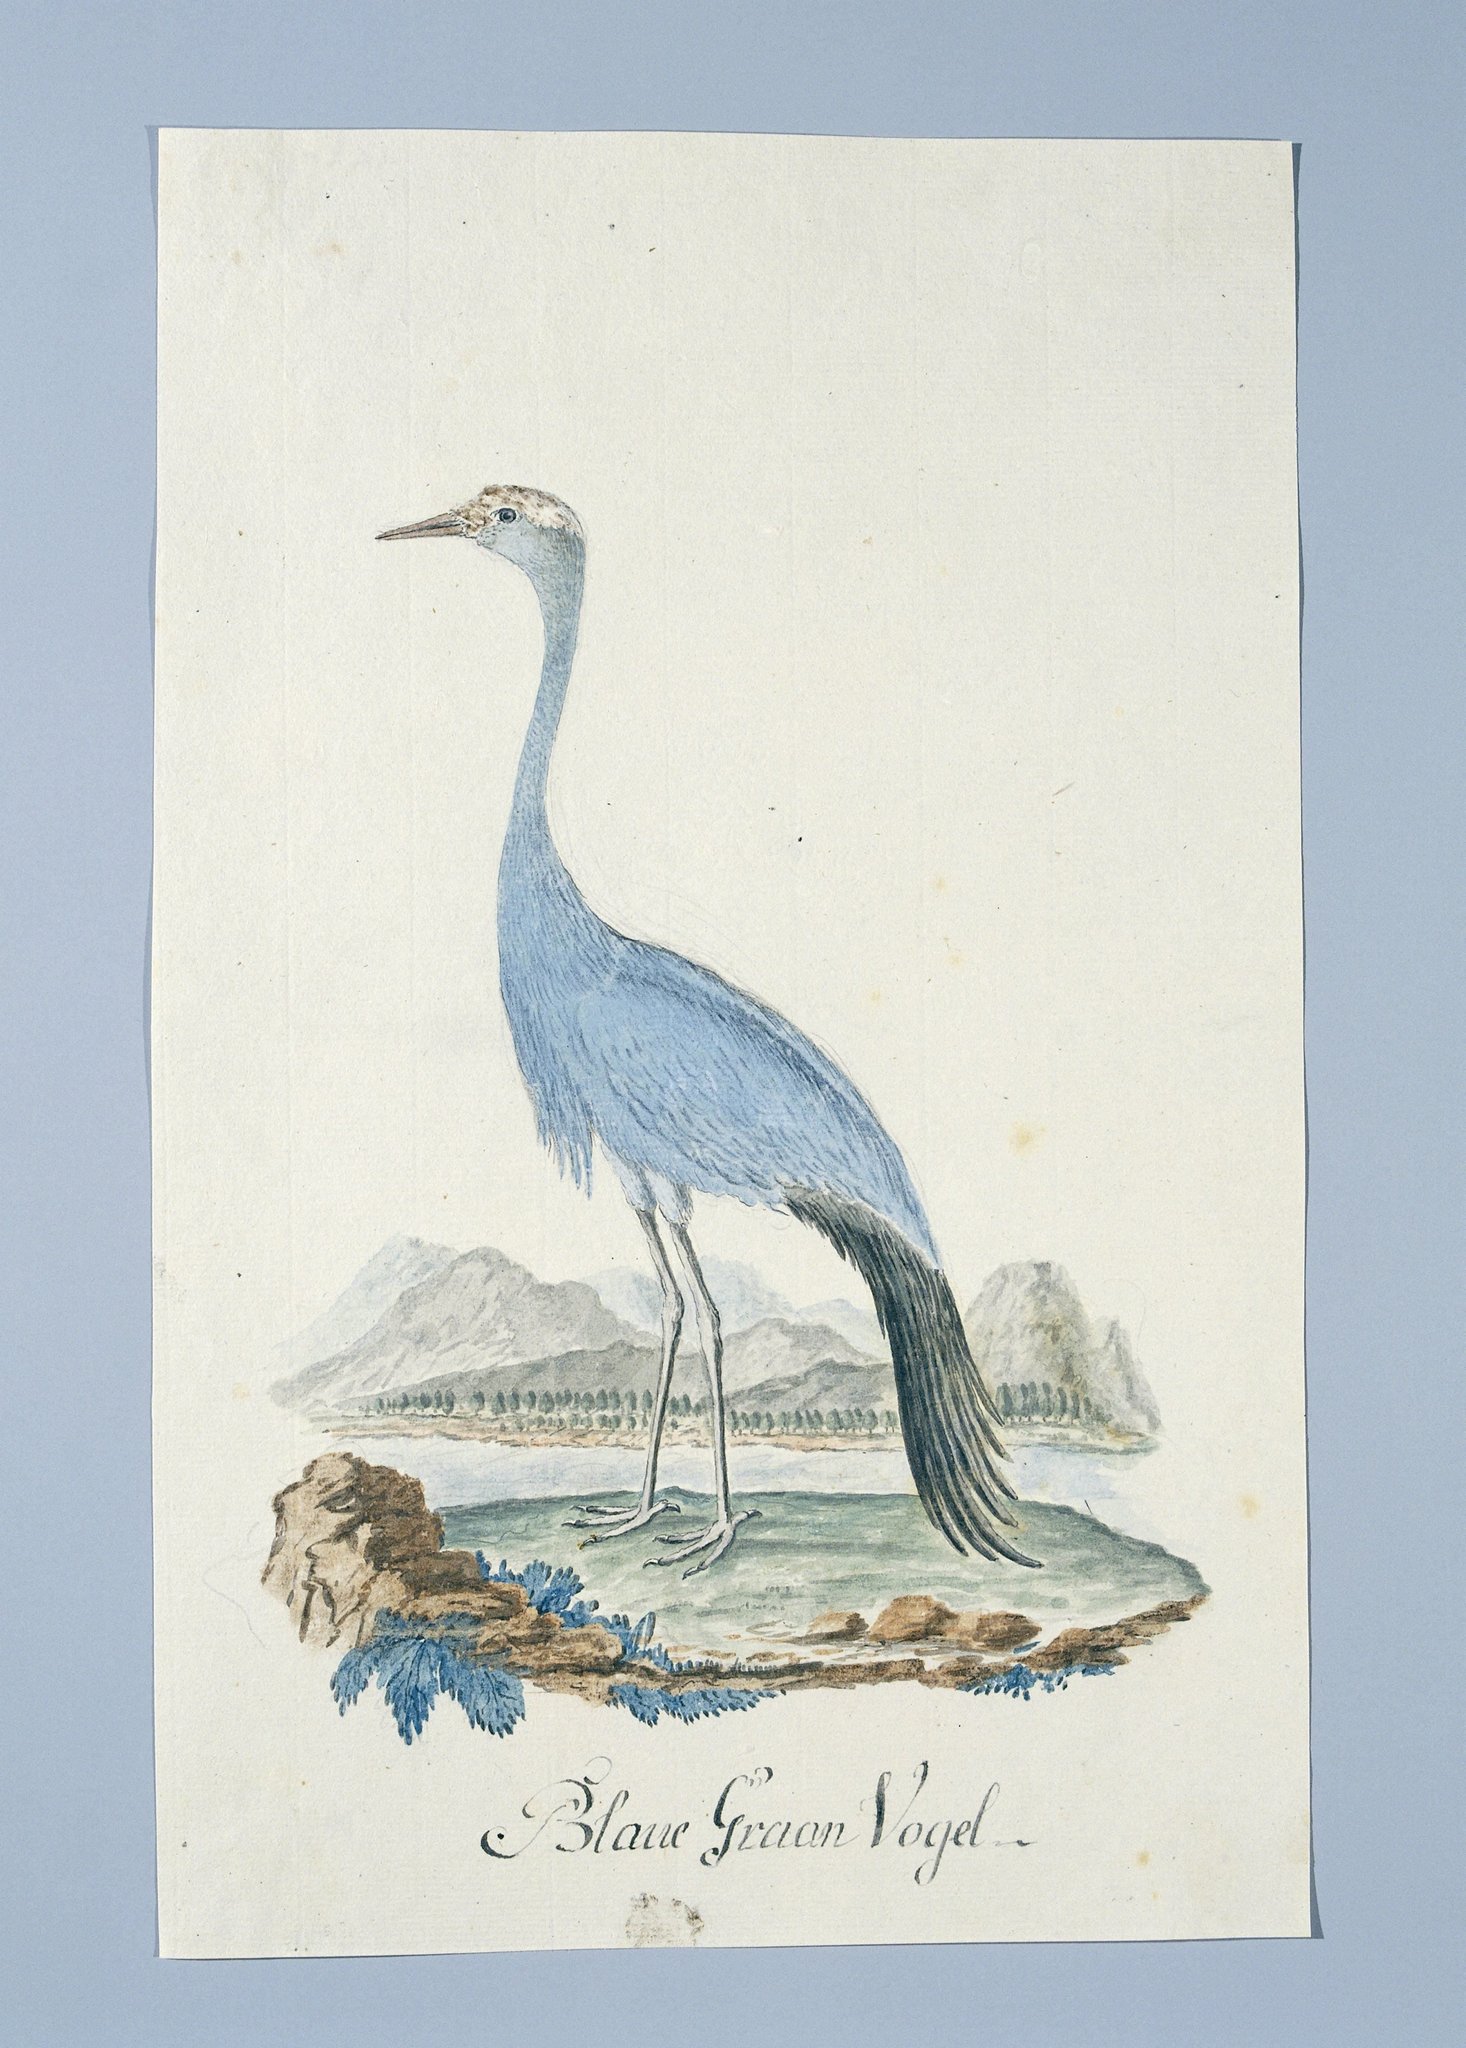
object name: album leaf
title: Anthropoides paradisea (Blue crane or Stanley crane)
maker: robert jacob gordon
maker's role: draughtsman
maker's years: 1743-1795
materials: chalk, ink, paper, pencil, watercolor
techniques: brush, pen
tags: shore-birds and wading-birds: crane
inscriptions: annotation: ‘Blaue Graan Vogel.’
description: Vogelstudie: Blauwe kraanvogel (Anthropoides paradisea).